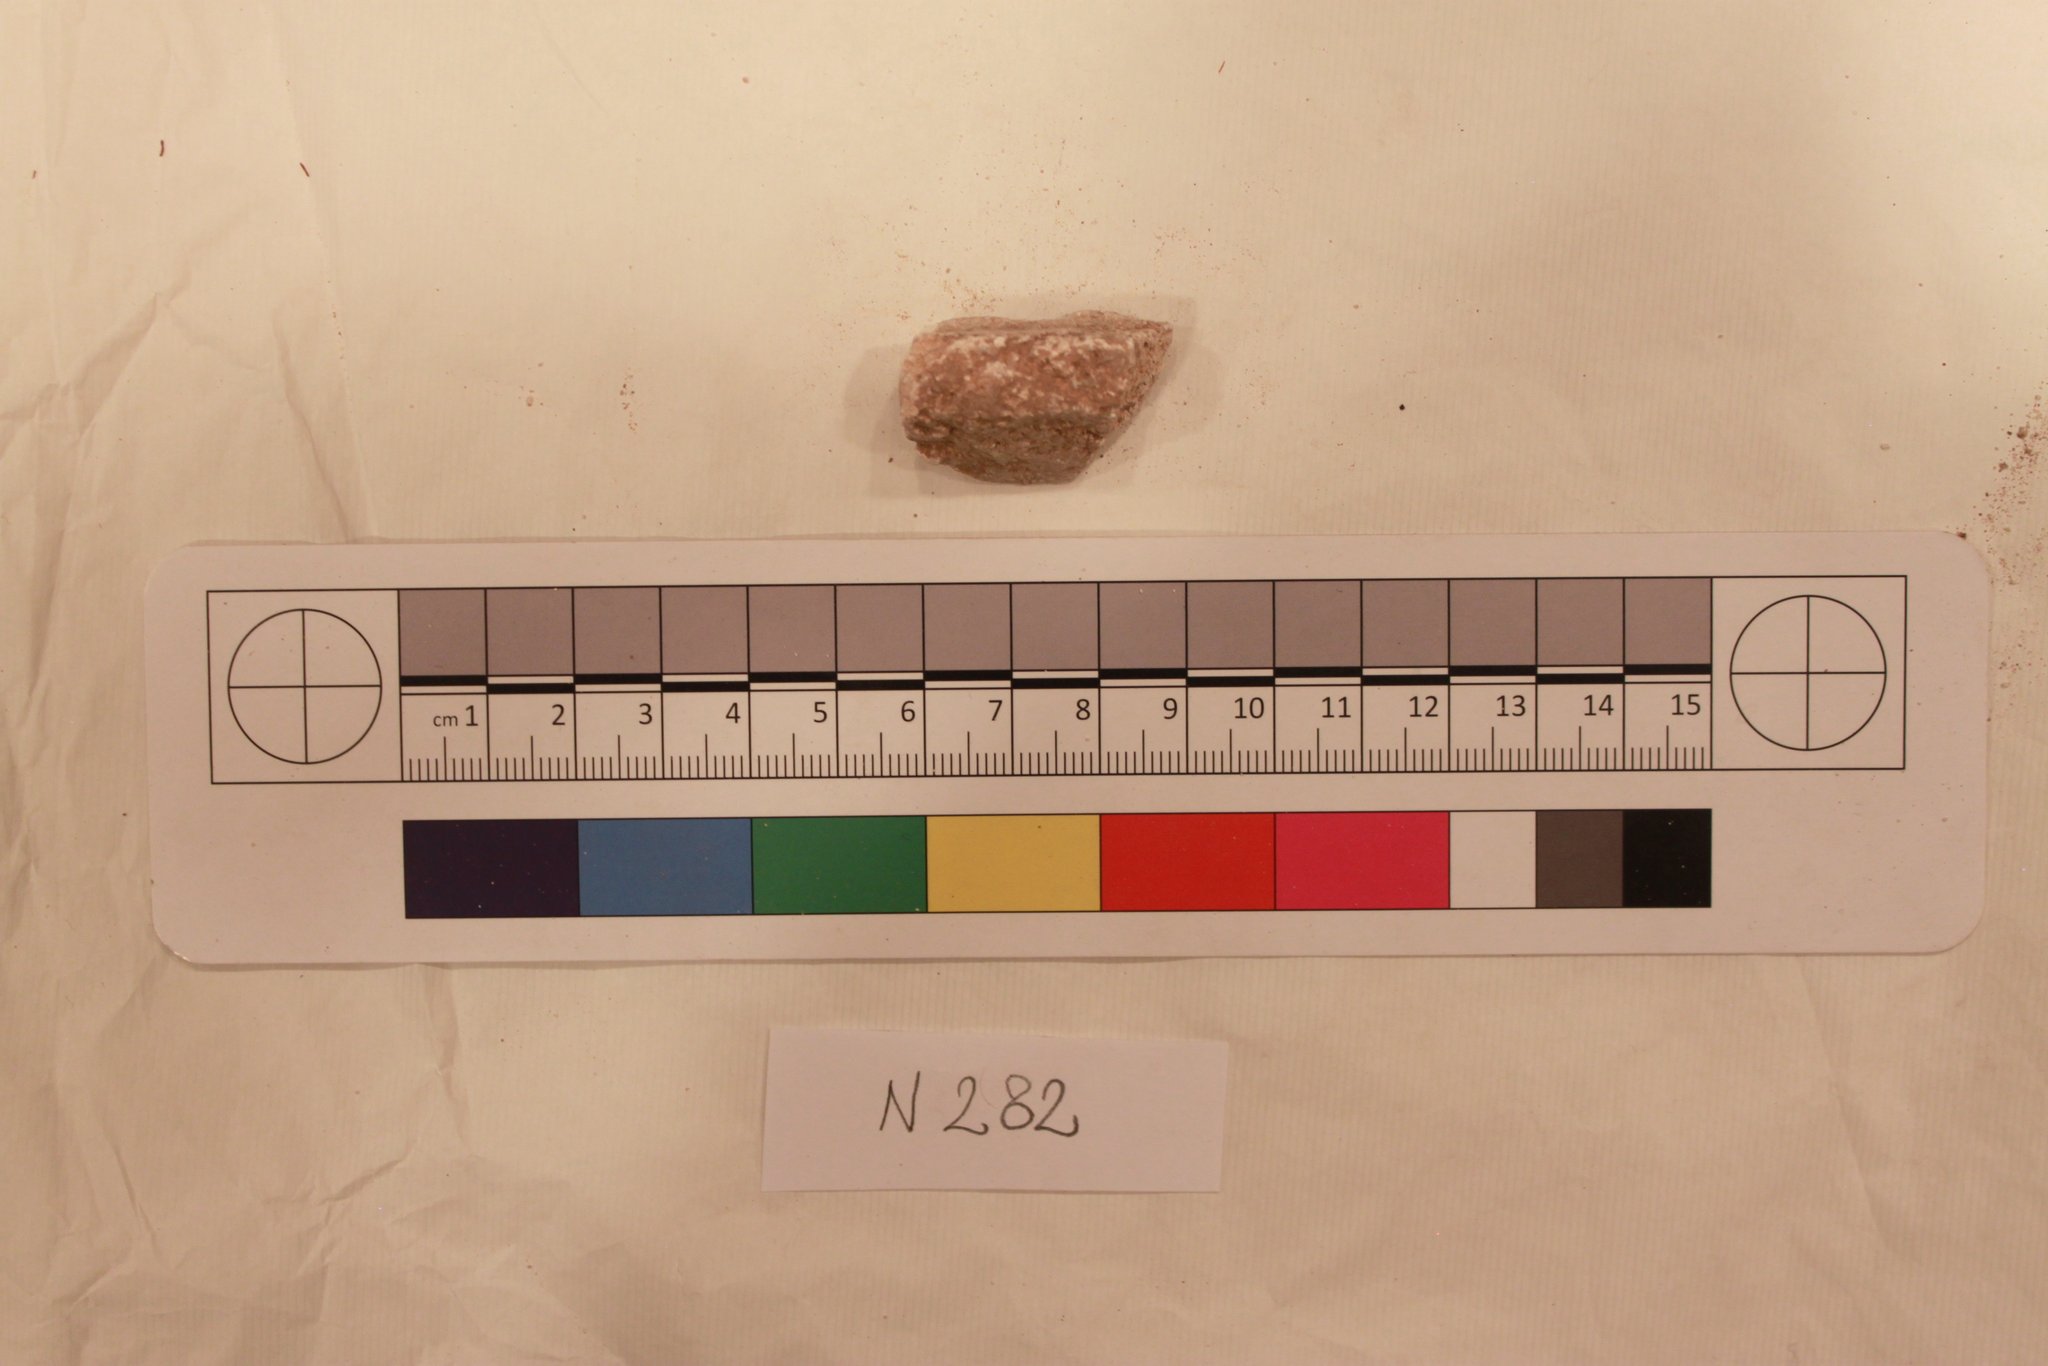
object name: fragment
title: Stucco Fragment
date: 701-1200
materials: plaster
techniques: carving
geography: iran